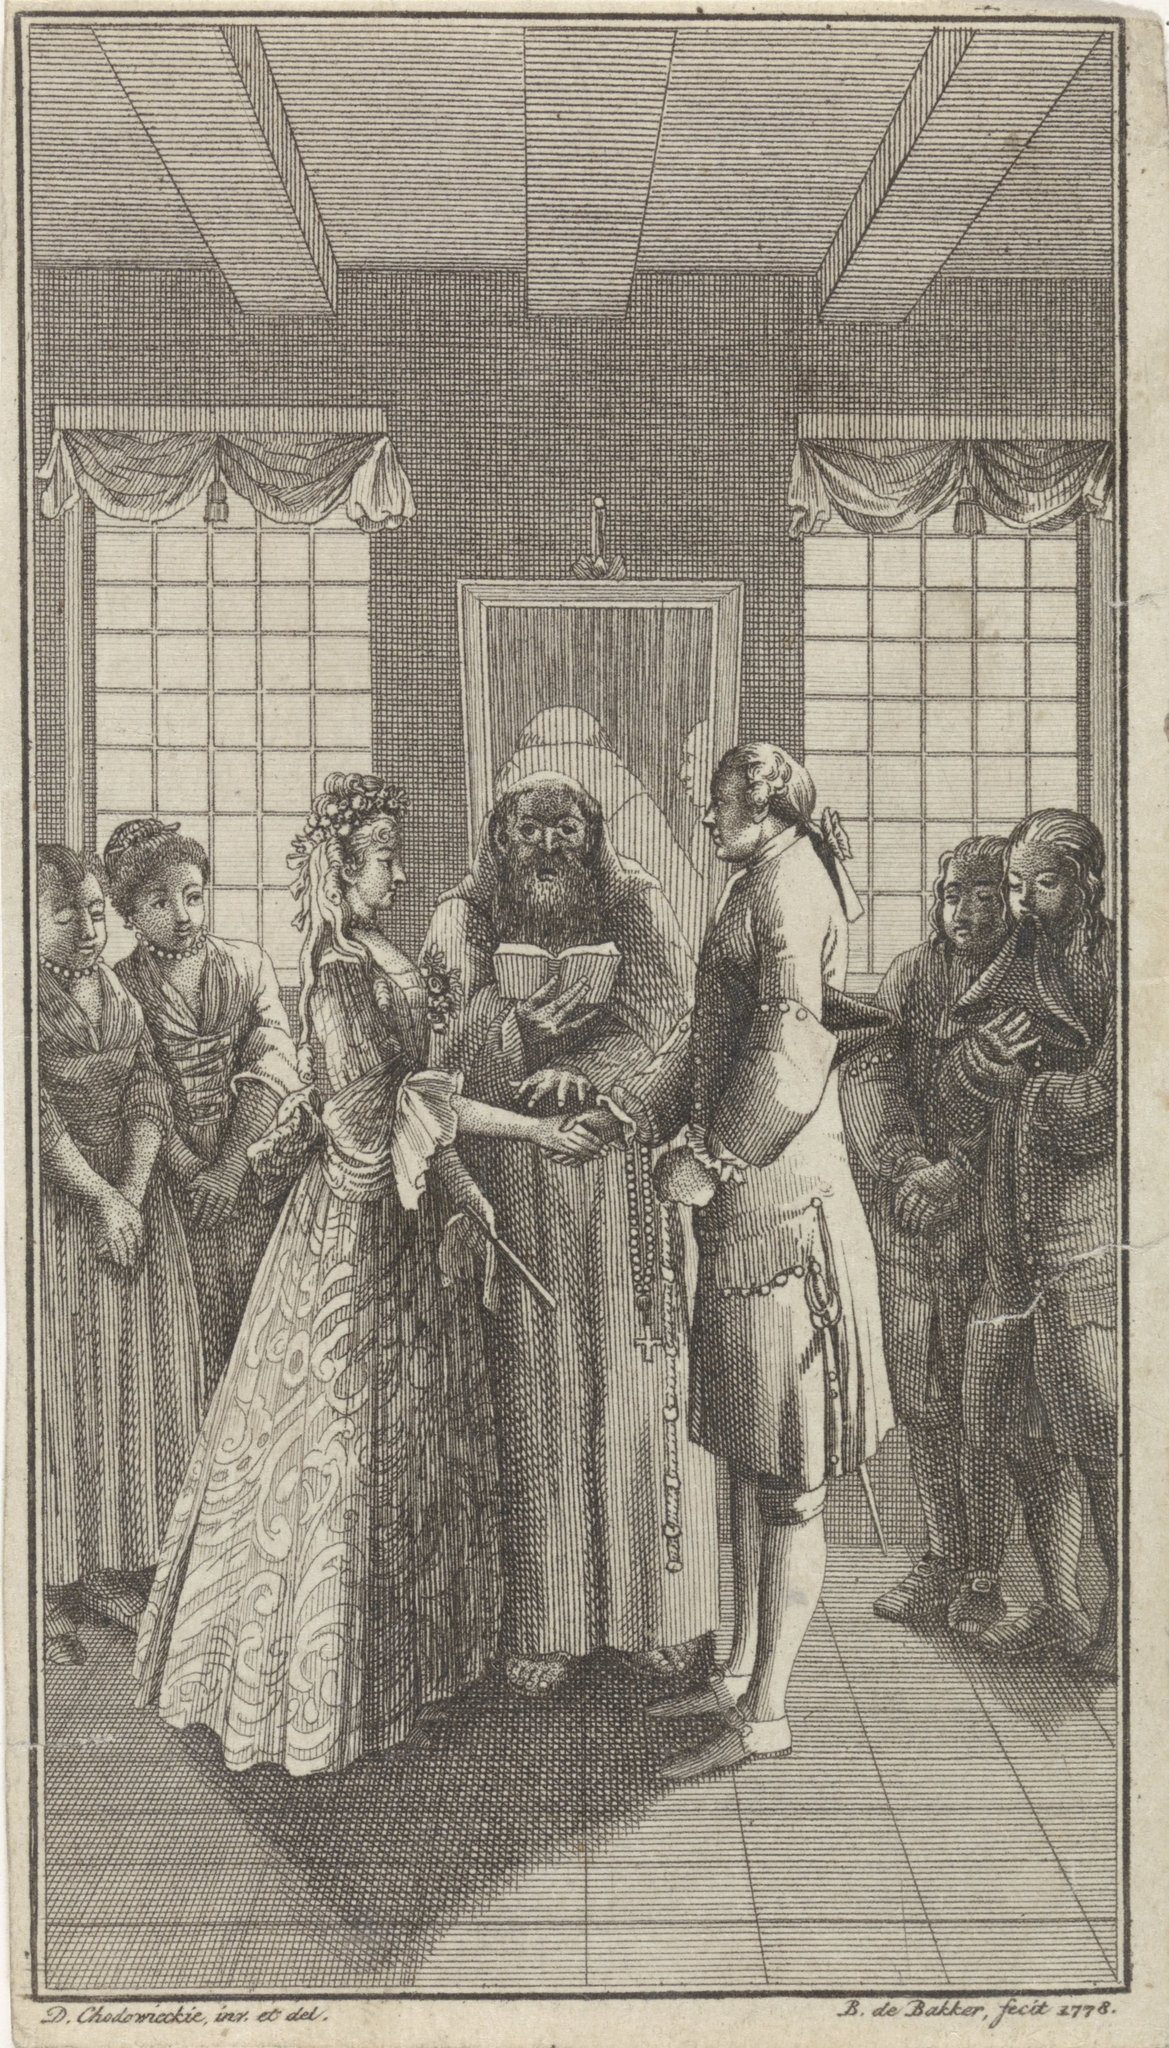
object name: print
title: Priester sluit huwelijk van man en vrouw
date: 1778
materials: paper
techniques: engraving, etching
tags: (civil) marriage ceremonies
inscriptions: collector's mark: Lugt 2228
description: Prent naar tekening van Daniel Nikolaus Chodowiecki.